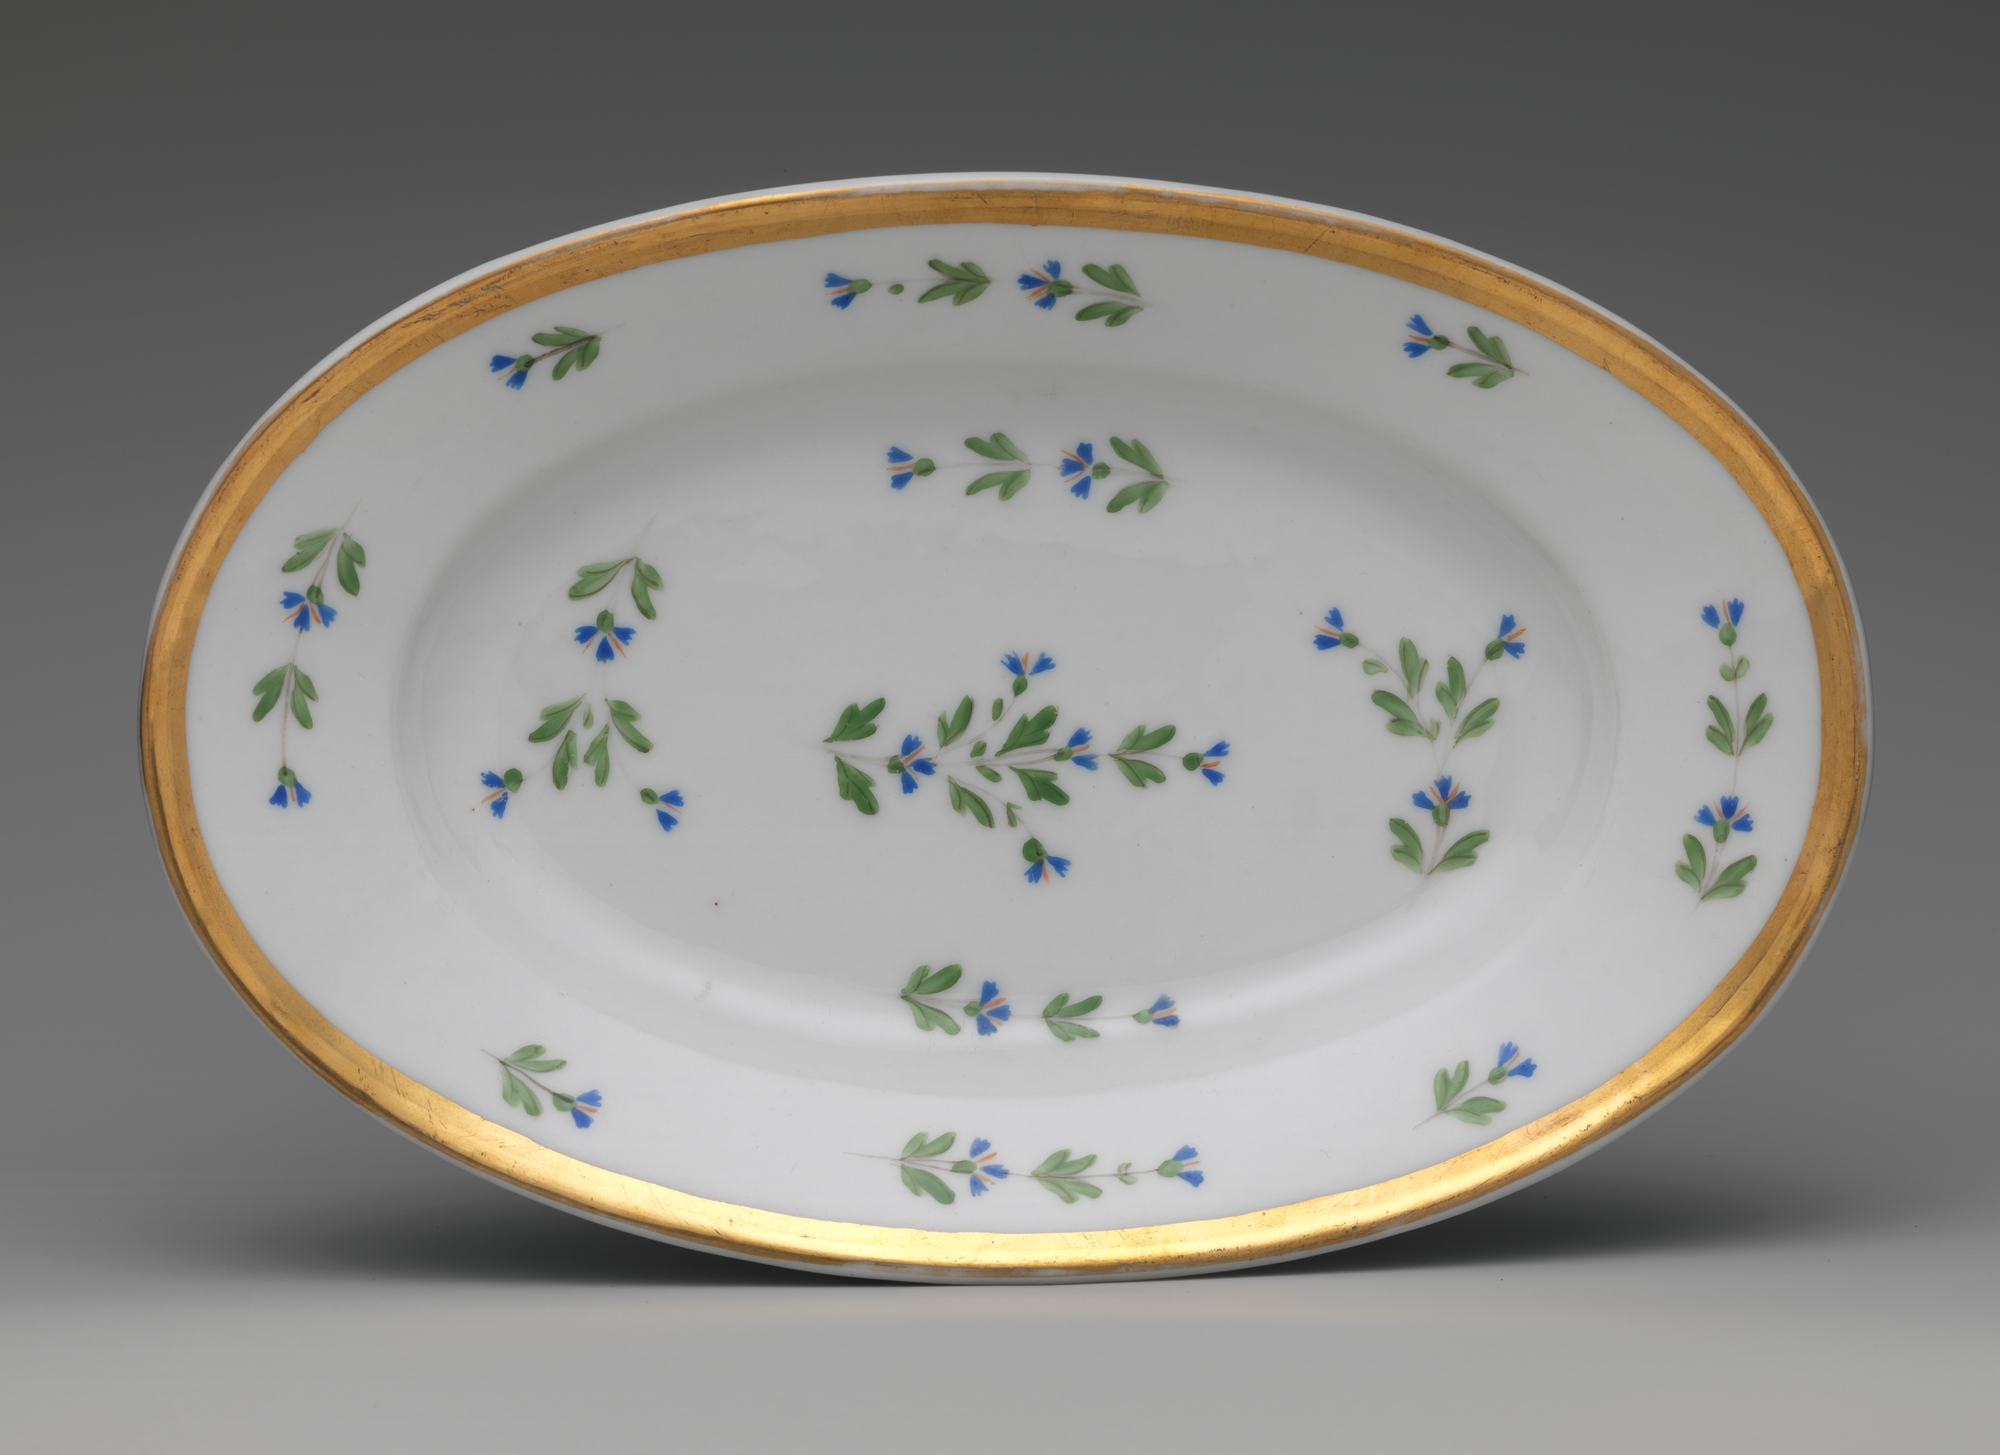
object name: platter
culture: french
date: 1815-1830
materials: porcelain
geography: france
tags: flowers